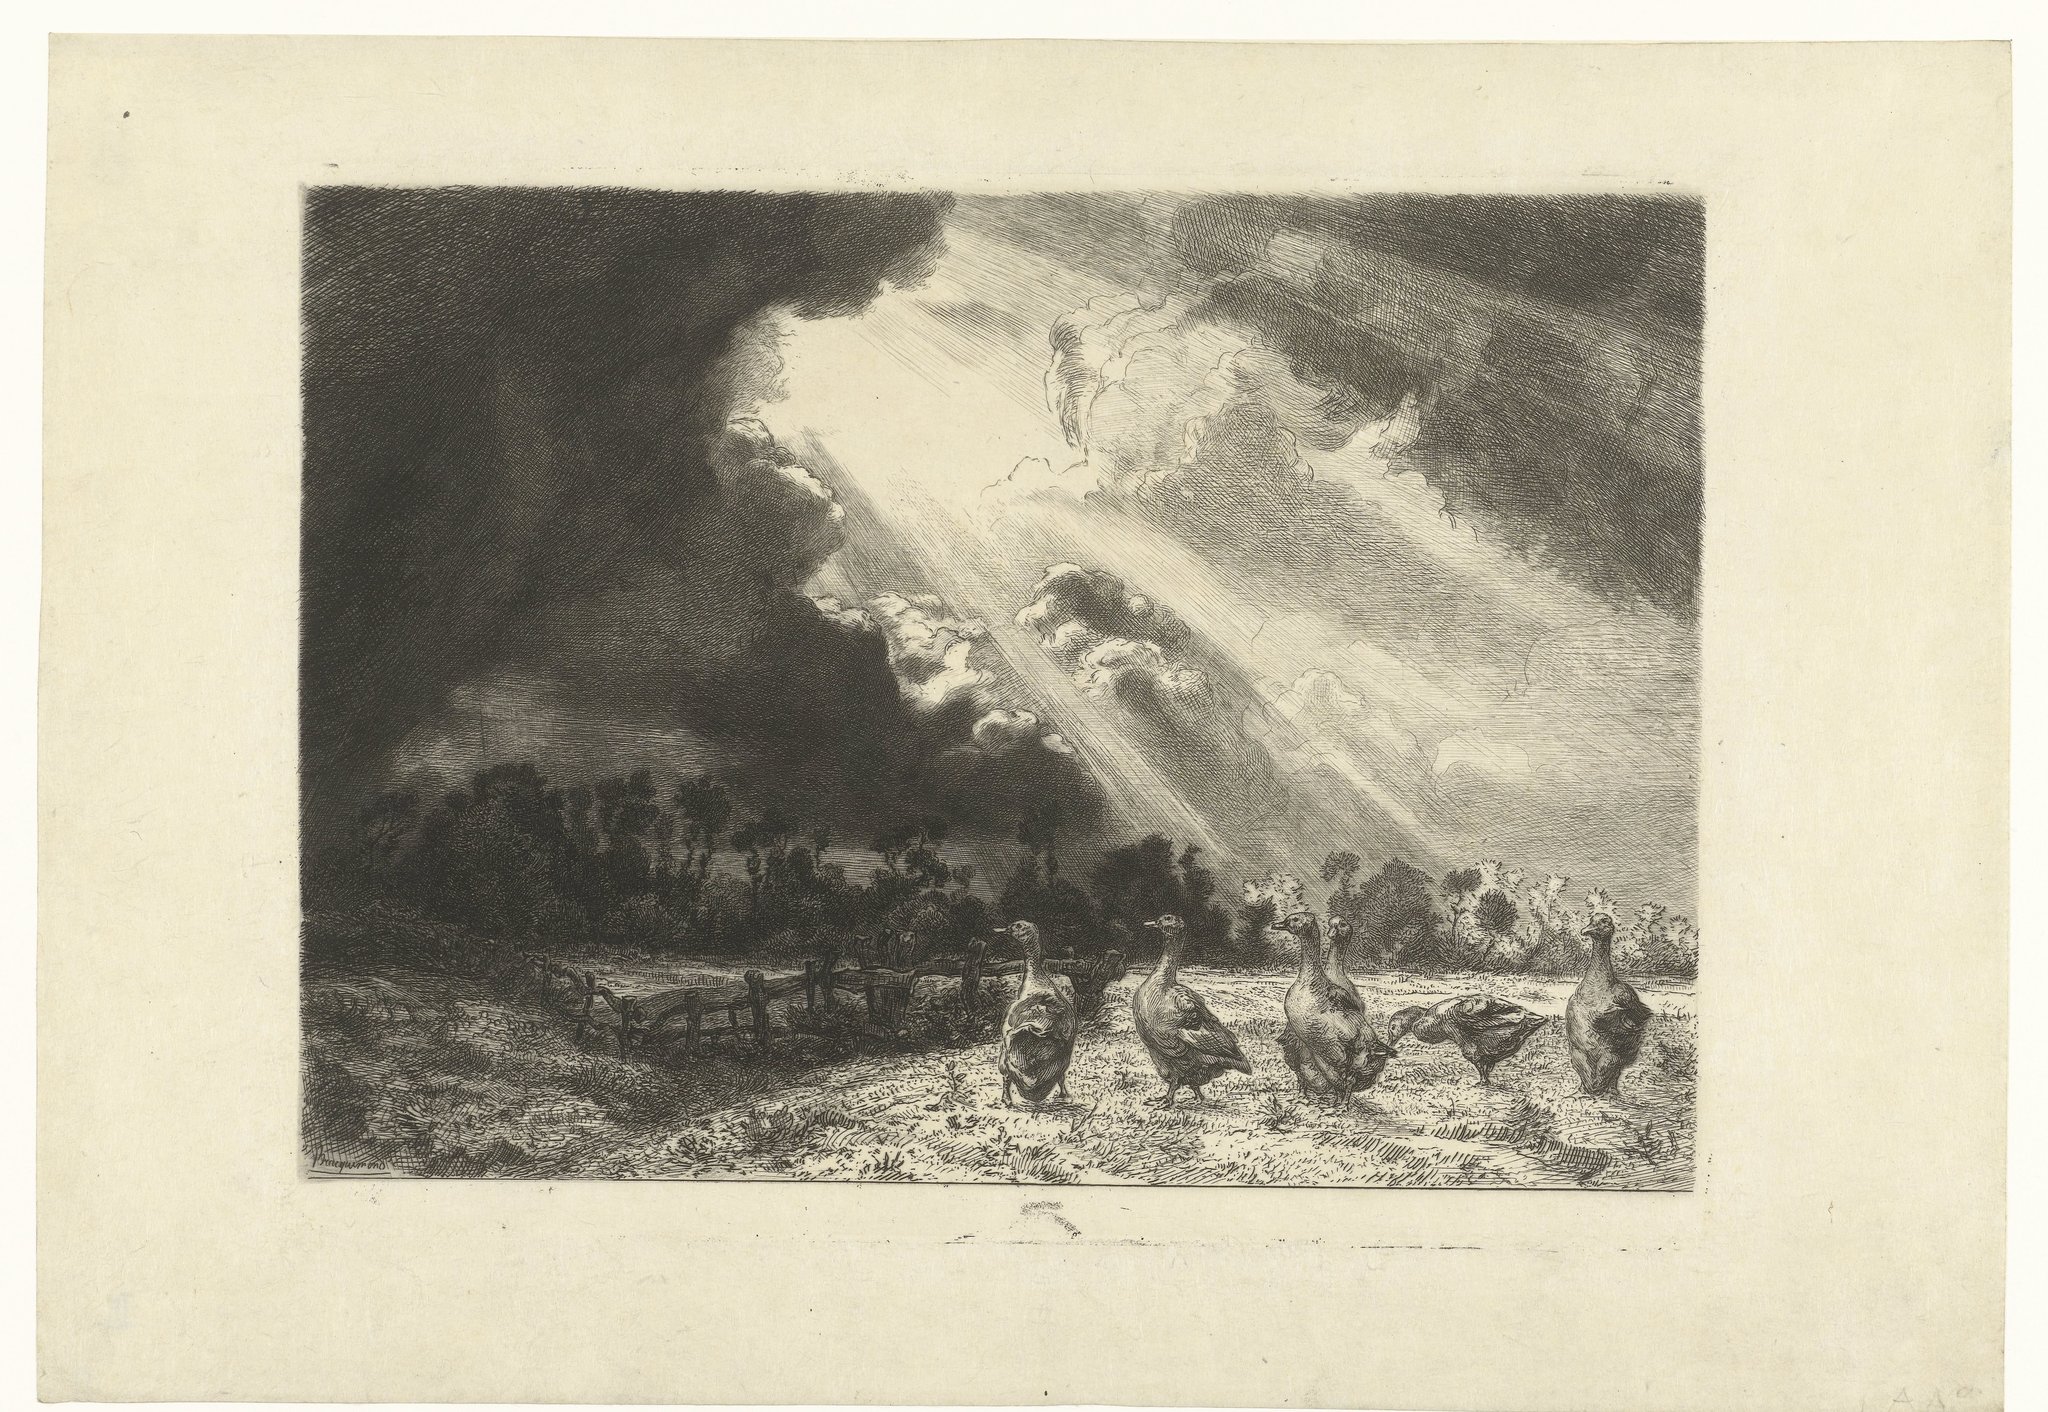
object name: print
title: Landschap met naderende onweersbui en ganzen in weide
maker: félix bracquemond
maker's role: print maker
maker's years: 1833-1914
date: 1860-1914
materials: paper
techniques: etching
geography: france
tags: meadow, pasture, cumulonimbus, i.e. thunder clouds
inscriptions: collector's mark: Lugt 2228, collector's mark: Lugt 2760, collector's mark: Lugt 1728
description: Landschap met een lage horizon en donkere wolkpartijen van een naderende onweersbui waar zonnestralen doorheen breken. Zes ganzen lopen in een weide en kijken gealarmeerd op van het grazen niet ver van een hek.